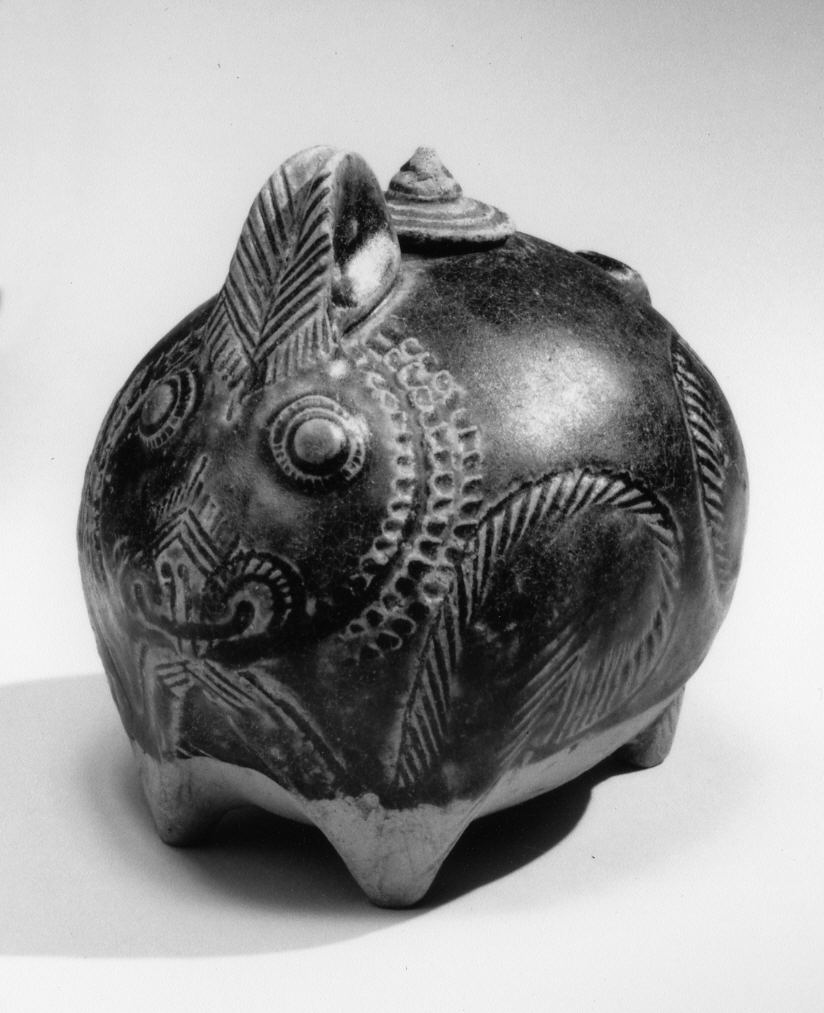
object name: covered lime pot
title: Covered Lime Pot in the Form of a Rabbit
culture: thai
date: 1151-1200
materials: stoneware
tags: rabbits